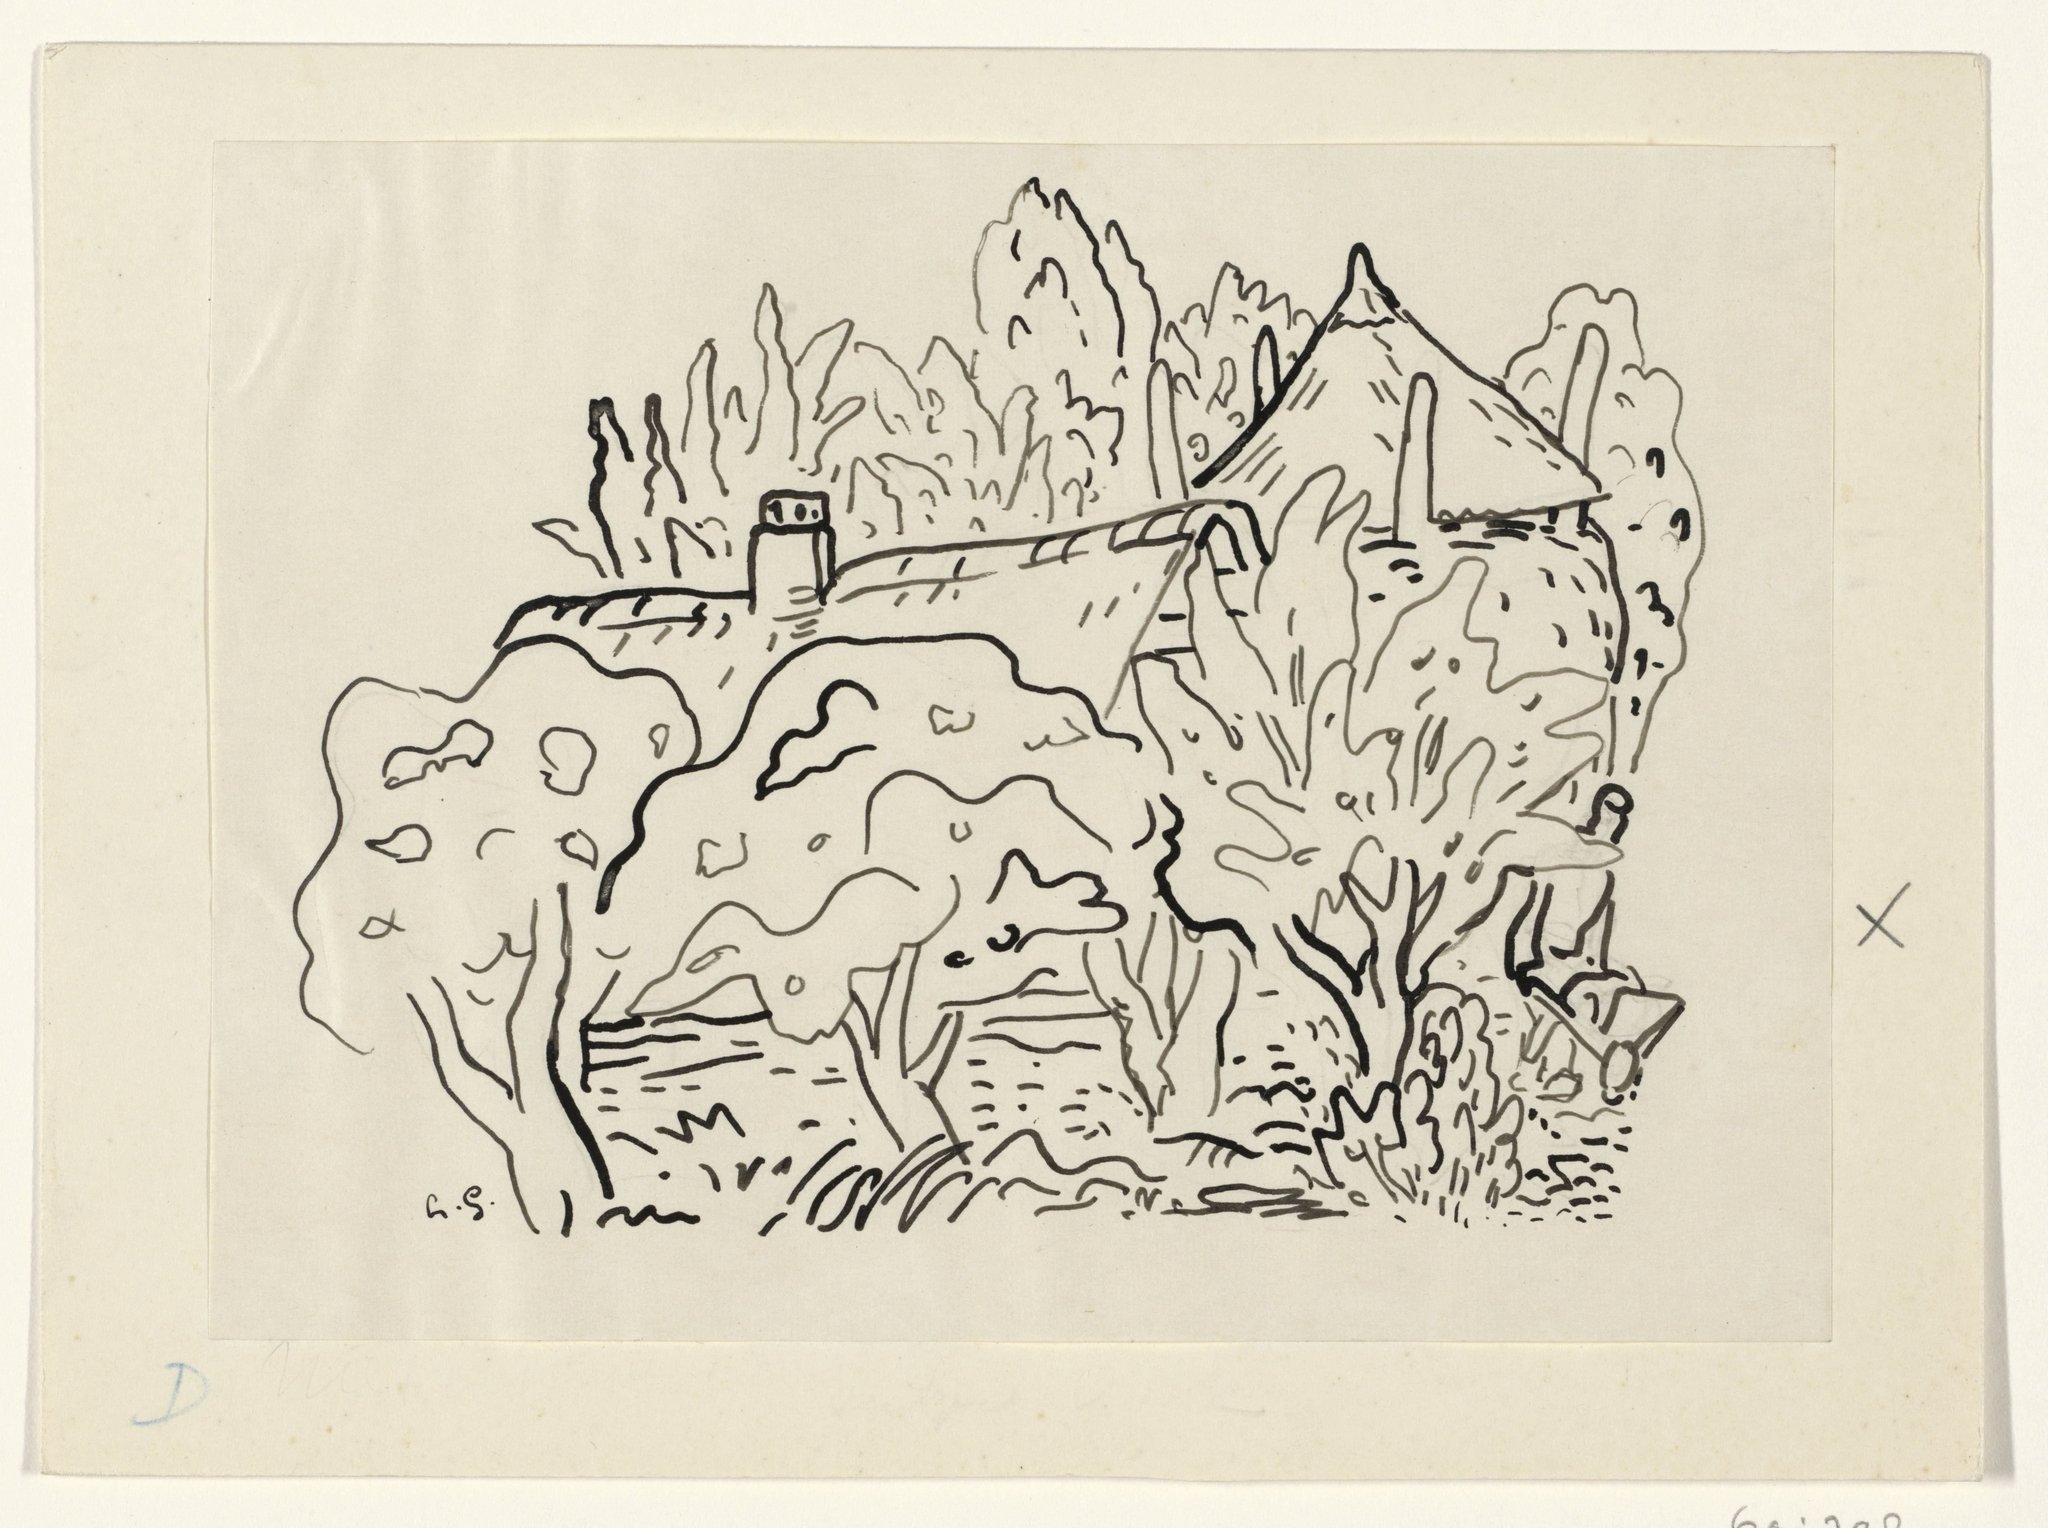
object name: drawing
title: Landschap met boerderij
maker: leo gestel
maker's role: draughtsman, print maker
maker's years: 1881-1941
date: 1891-1941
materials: ink, paper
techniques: pen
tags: farm or solitary house in landscape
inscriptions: collector's mark: Lugt 2228